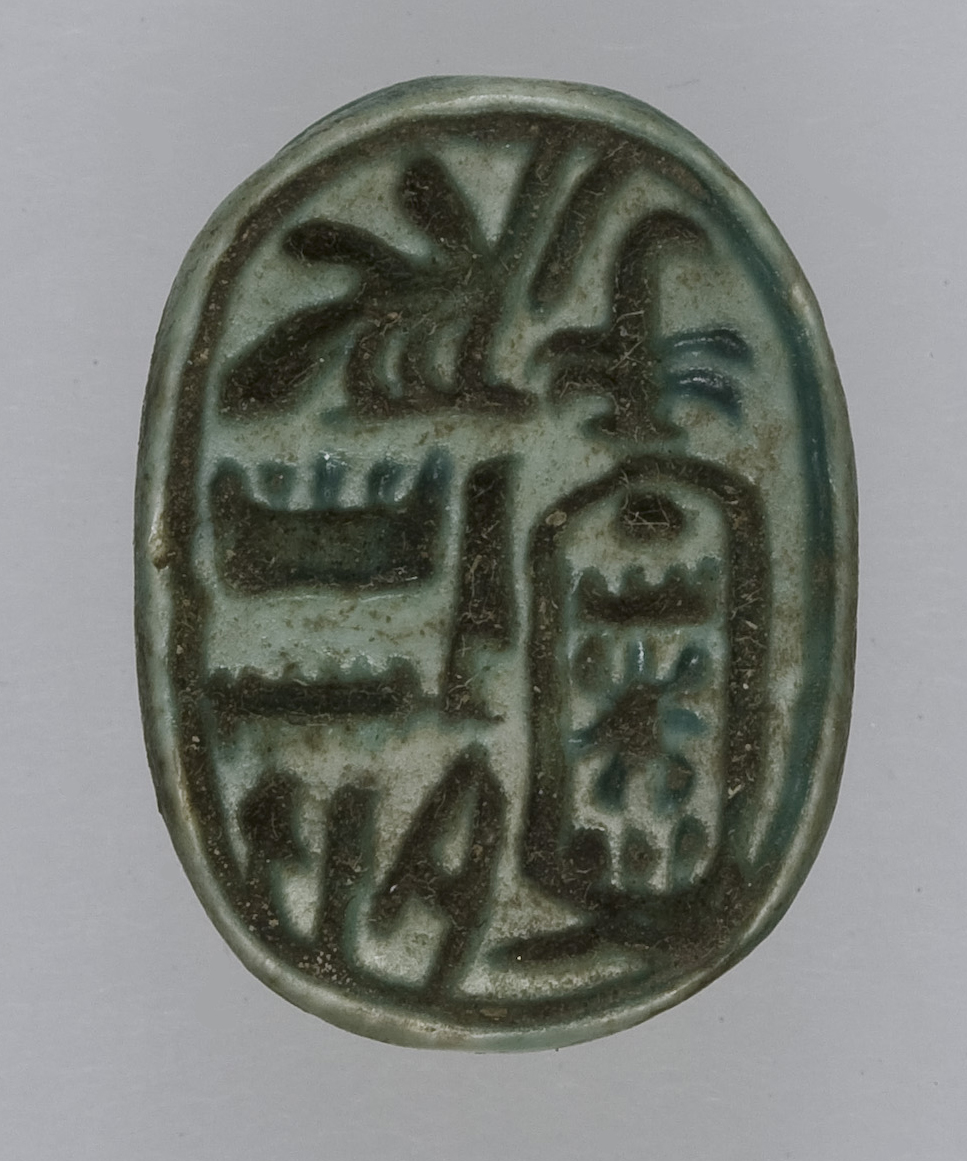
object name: scarab, thutmose iv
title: Scarab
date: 1400-1390 BCE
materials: stone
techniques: glazing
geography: egypt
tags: hieroglyphs,scarabs